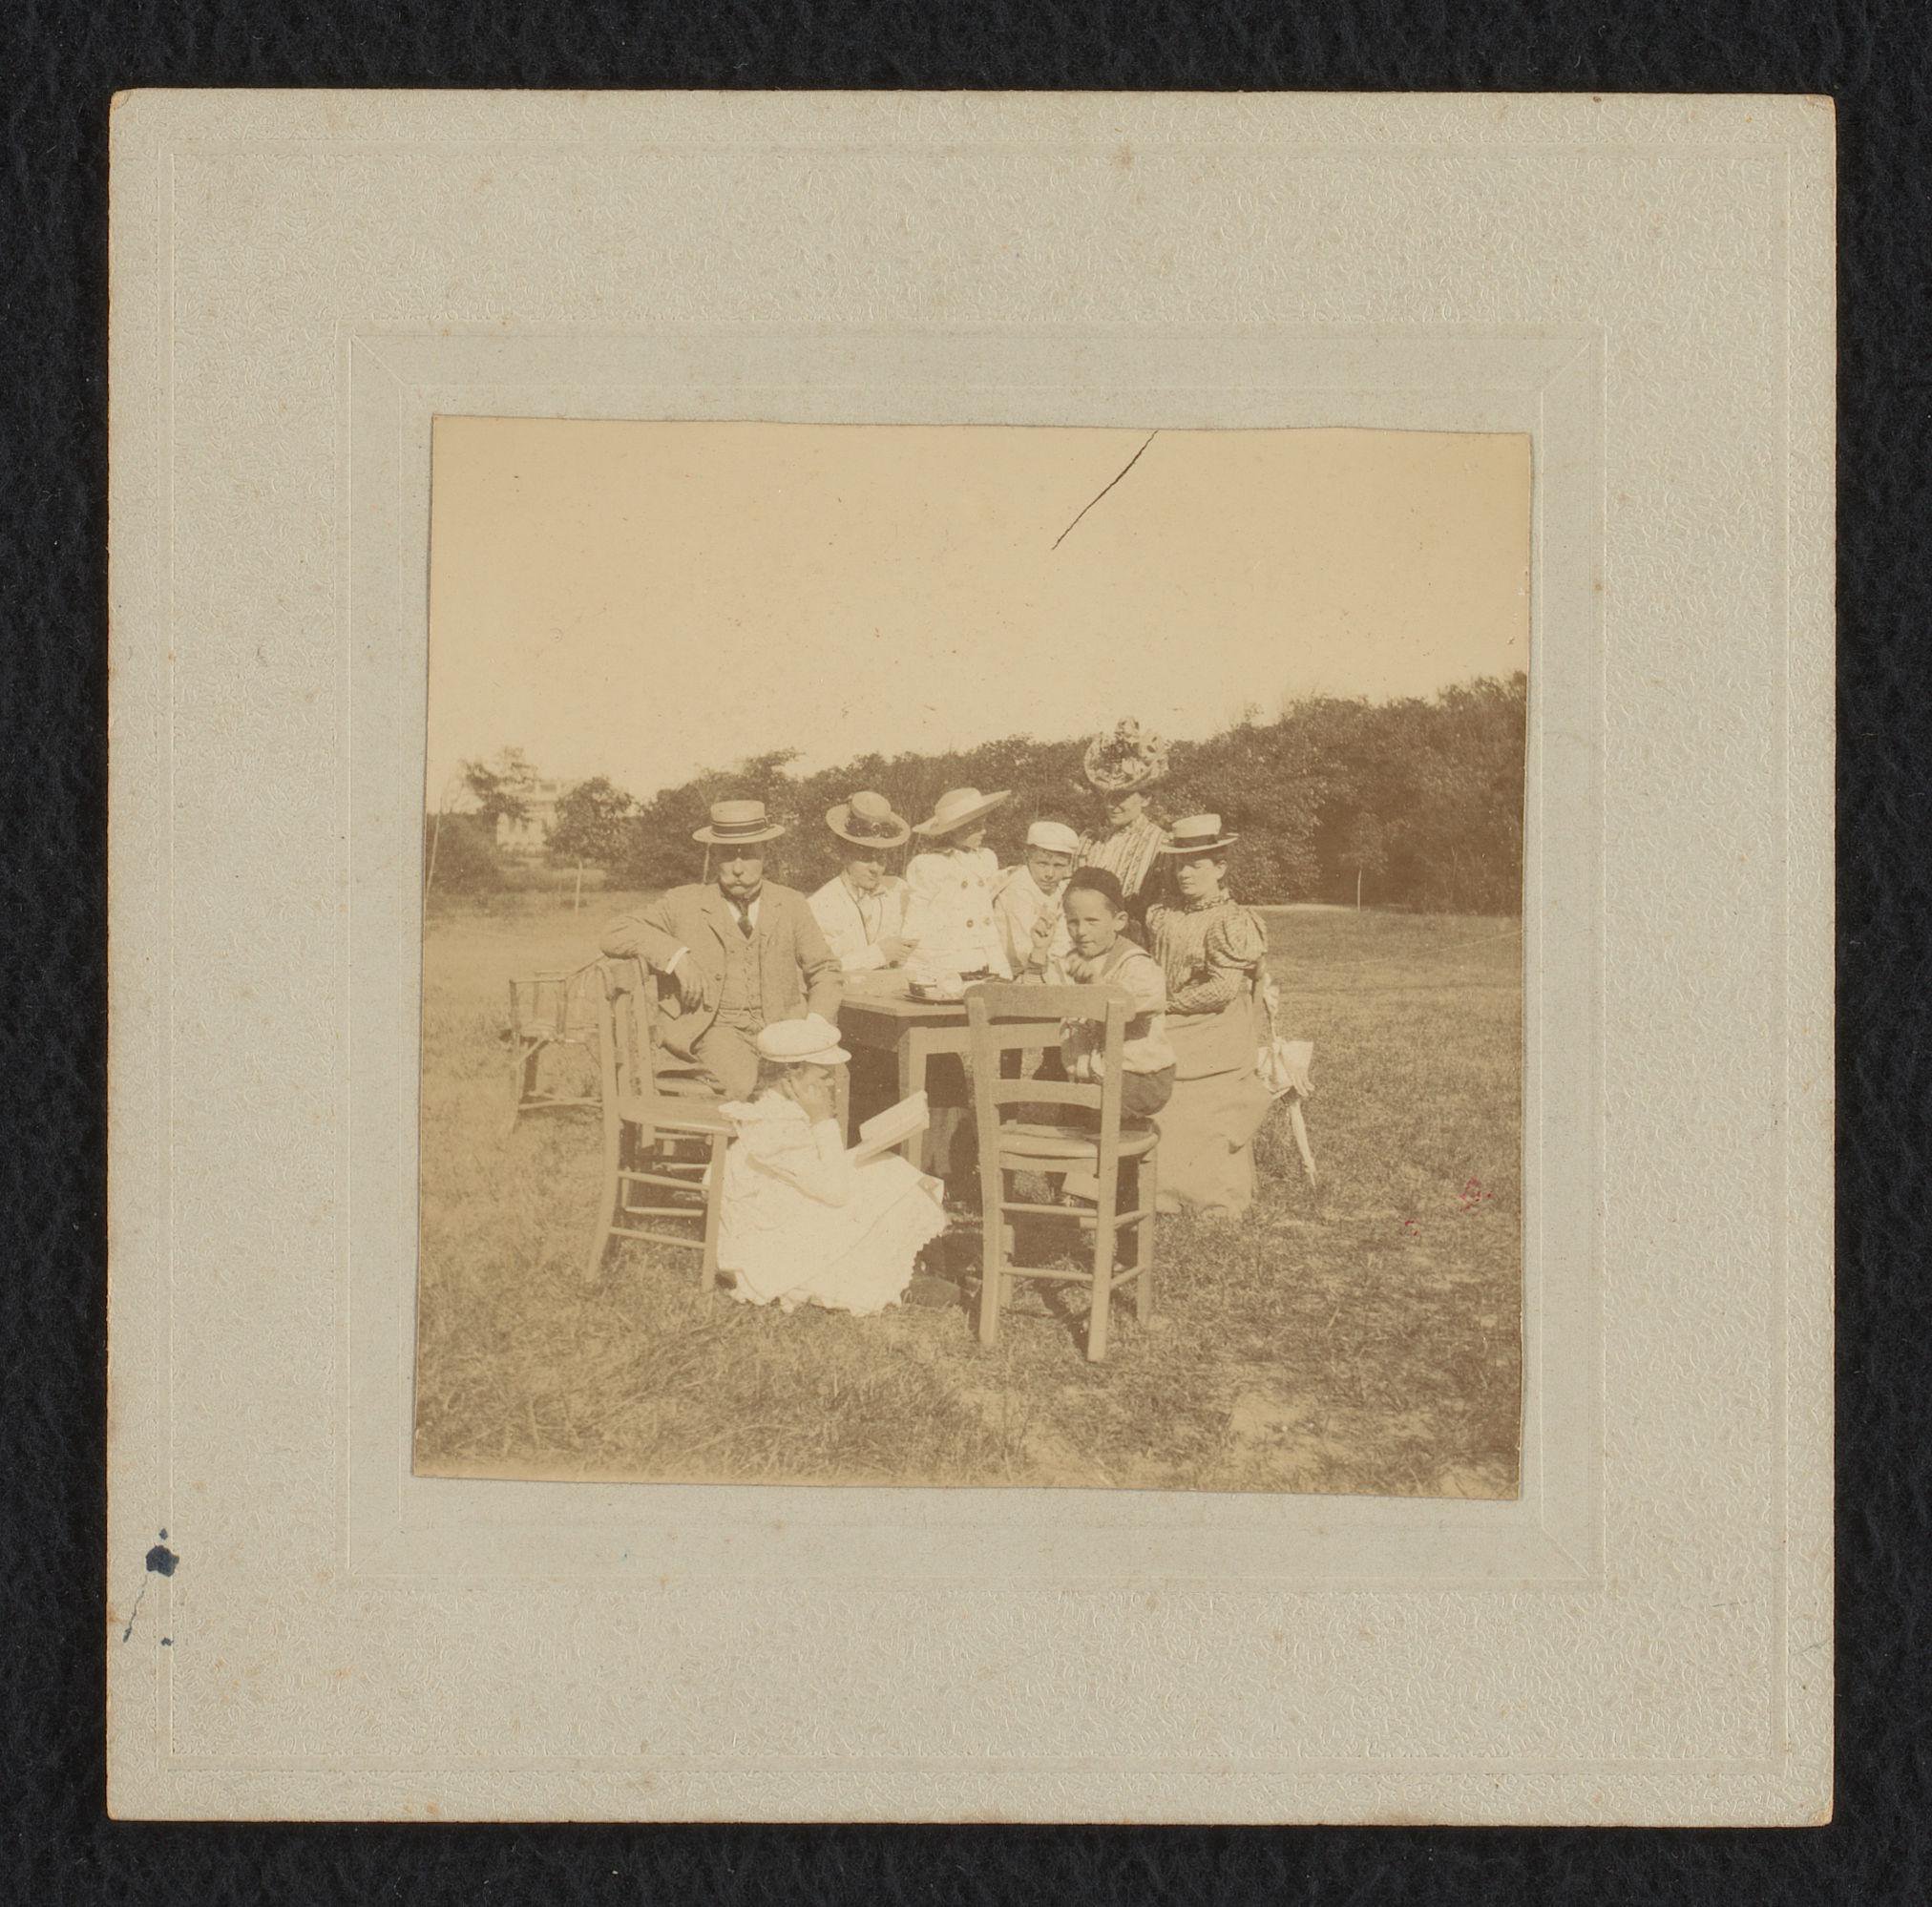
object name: photograph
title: Gezin van August Kessler, buiten aan een tafel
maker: jean baptiste august kessler (1853-1900)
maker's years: 1853-1900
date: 1895-1900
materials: paper, cardboard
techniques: collodion silver print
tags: the hague, jean baptiste august kessler (1888-1972), batavia, geldolph adriaan kessler (dolph), margaretha jacoba johanna kessler-de lange (margo), naples, jean baptiste august kessler (1853-1900), (family) meal - cc - out of doors